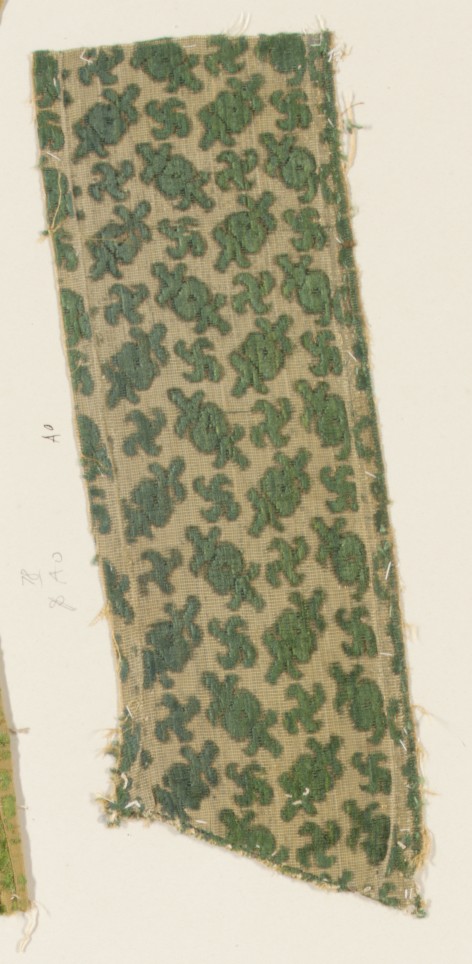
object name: fragment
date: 1501-1600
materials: silk